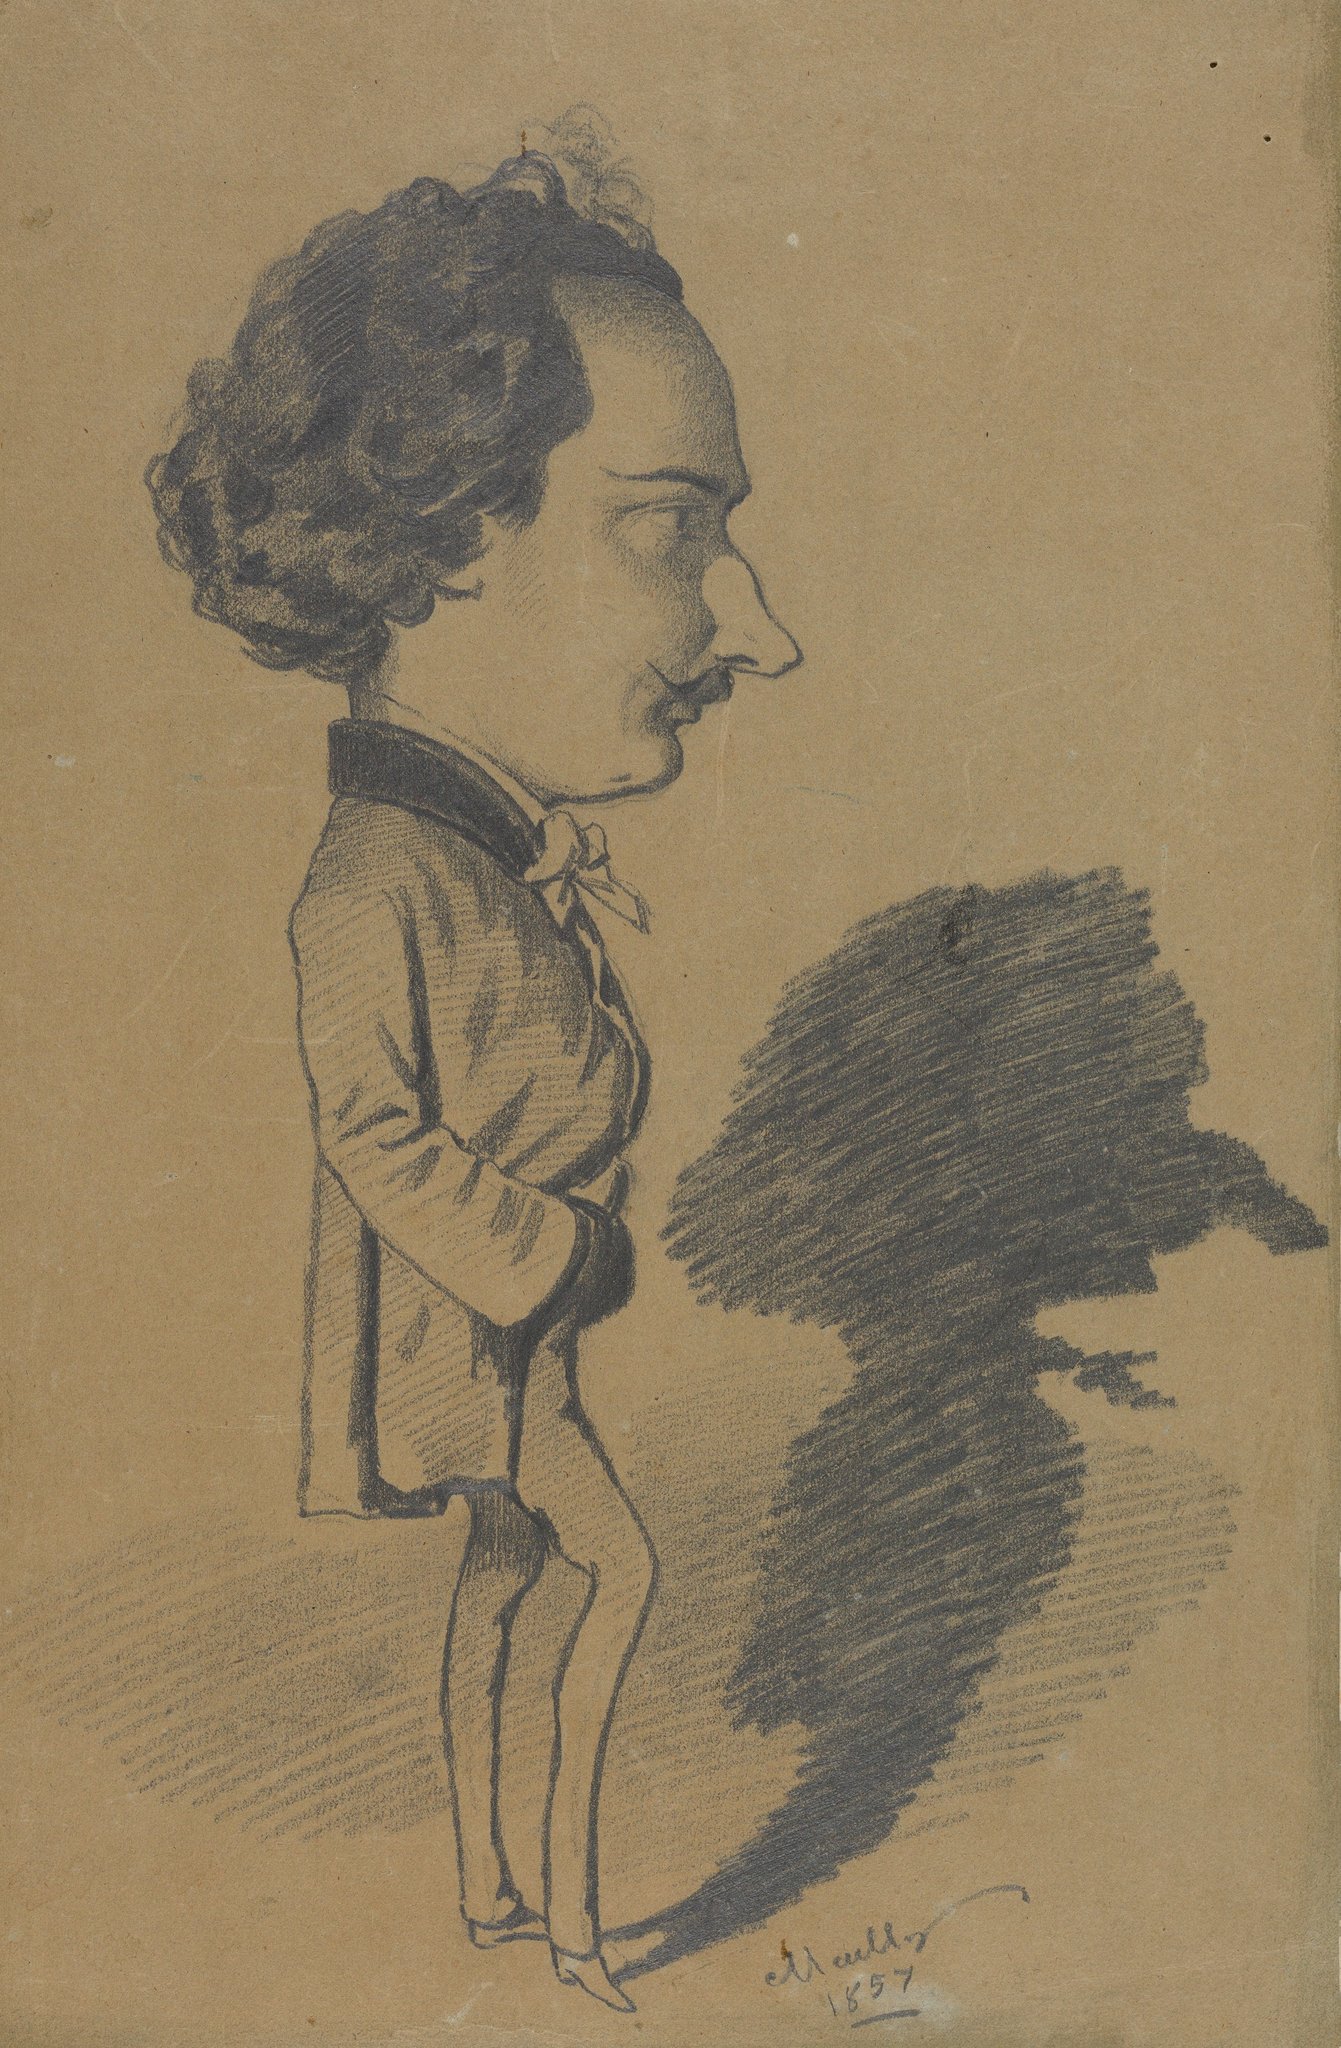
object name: drawing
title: Caricature of a Standing Man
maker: hippolyte mailly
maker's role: artist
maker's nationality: french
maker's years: 1829-1888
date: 1857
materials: graphite, paper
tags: satire,men,profiles